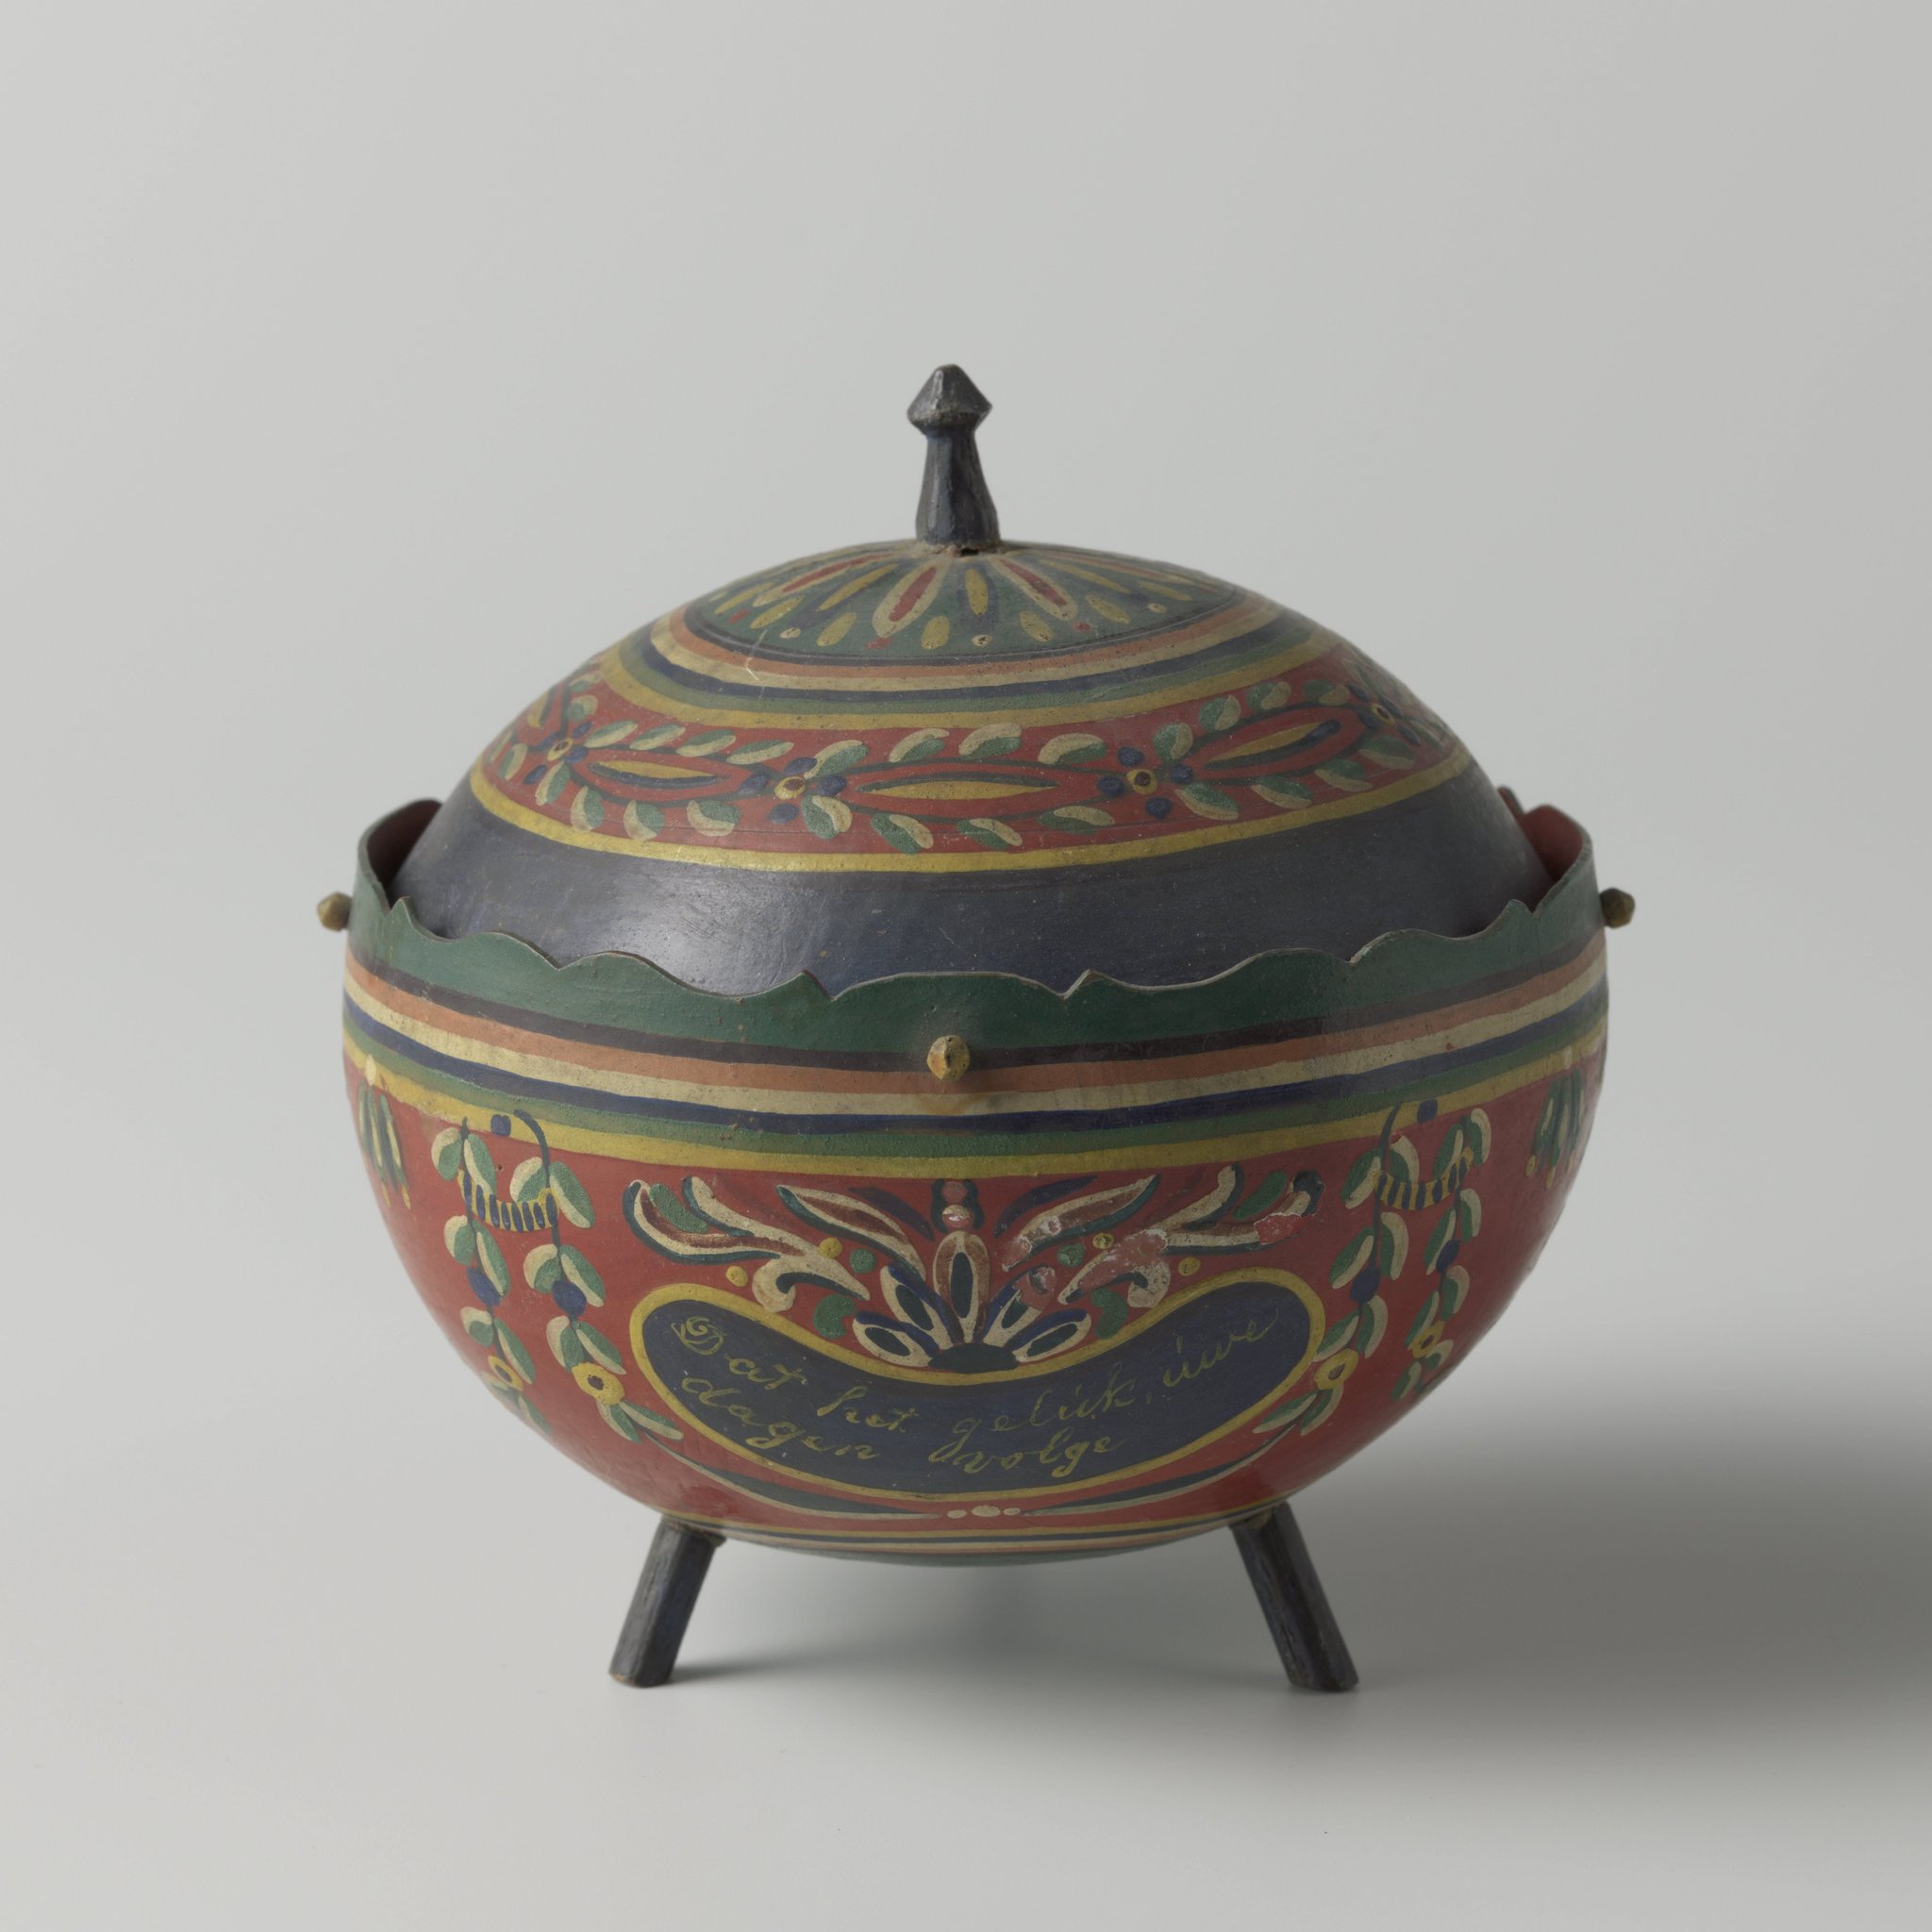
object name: box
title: Doos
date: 1400-1950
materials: paint, wood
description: Kleurig geschilderd rond doosje met deksel, op 3 pootjes. Opschrift: "Dat het geluk uwe dagen volge".